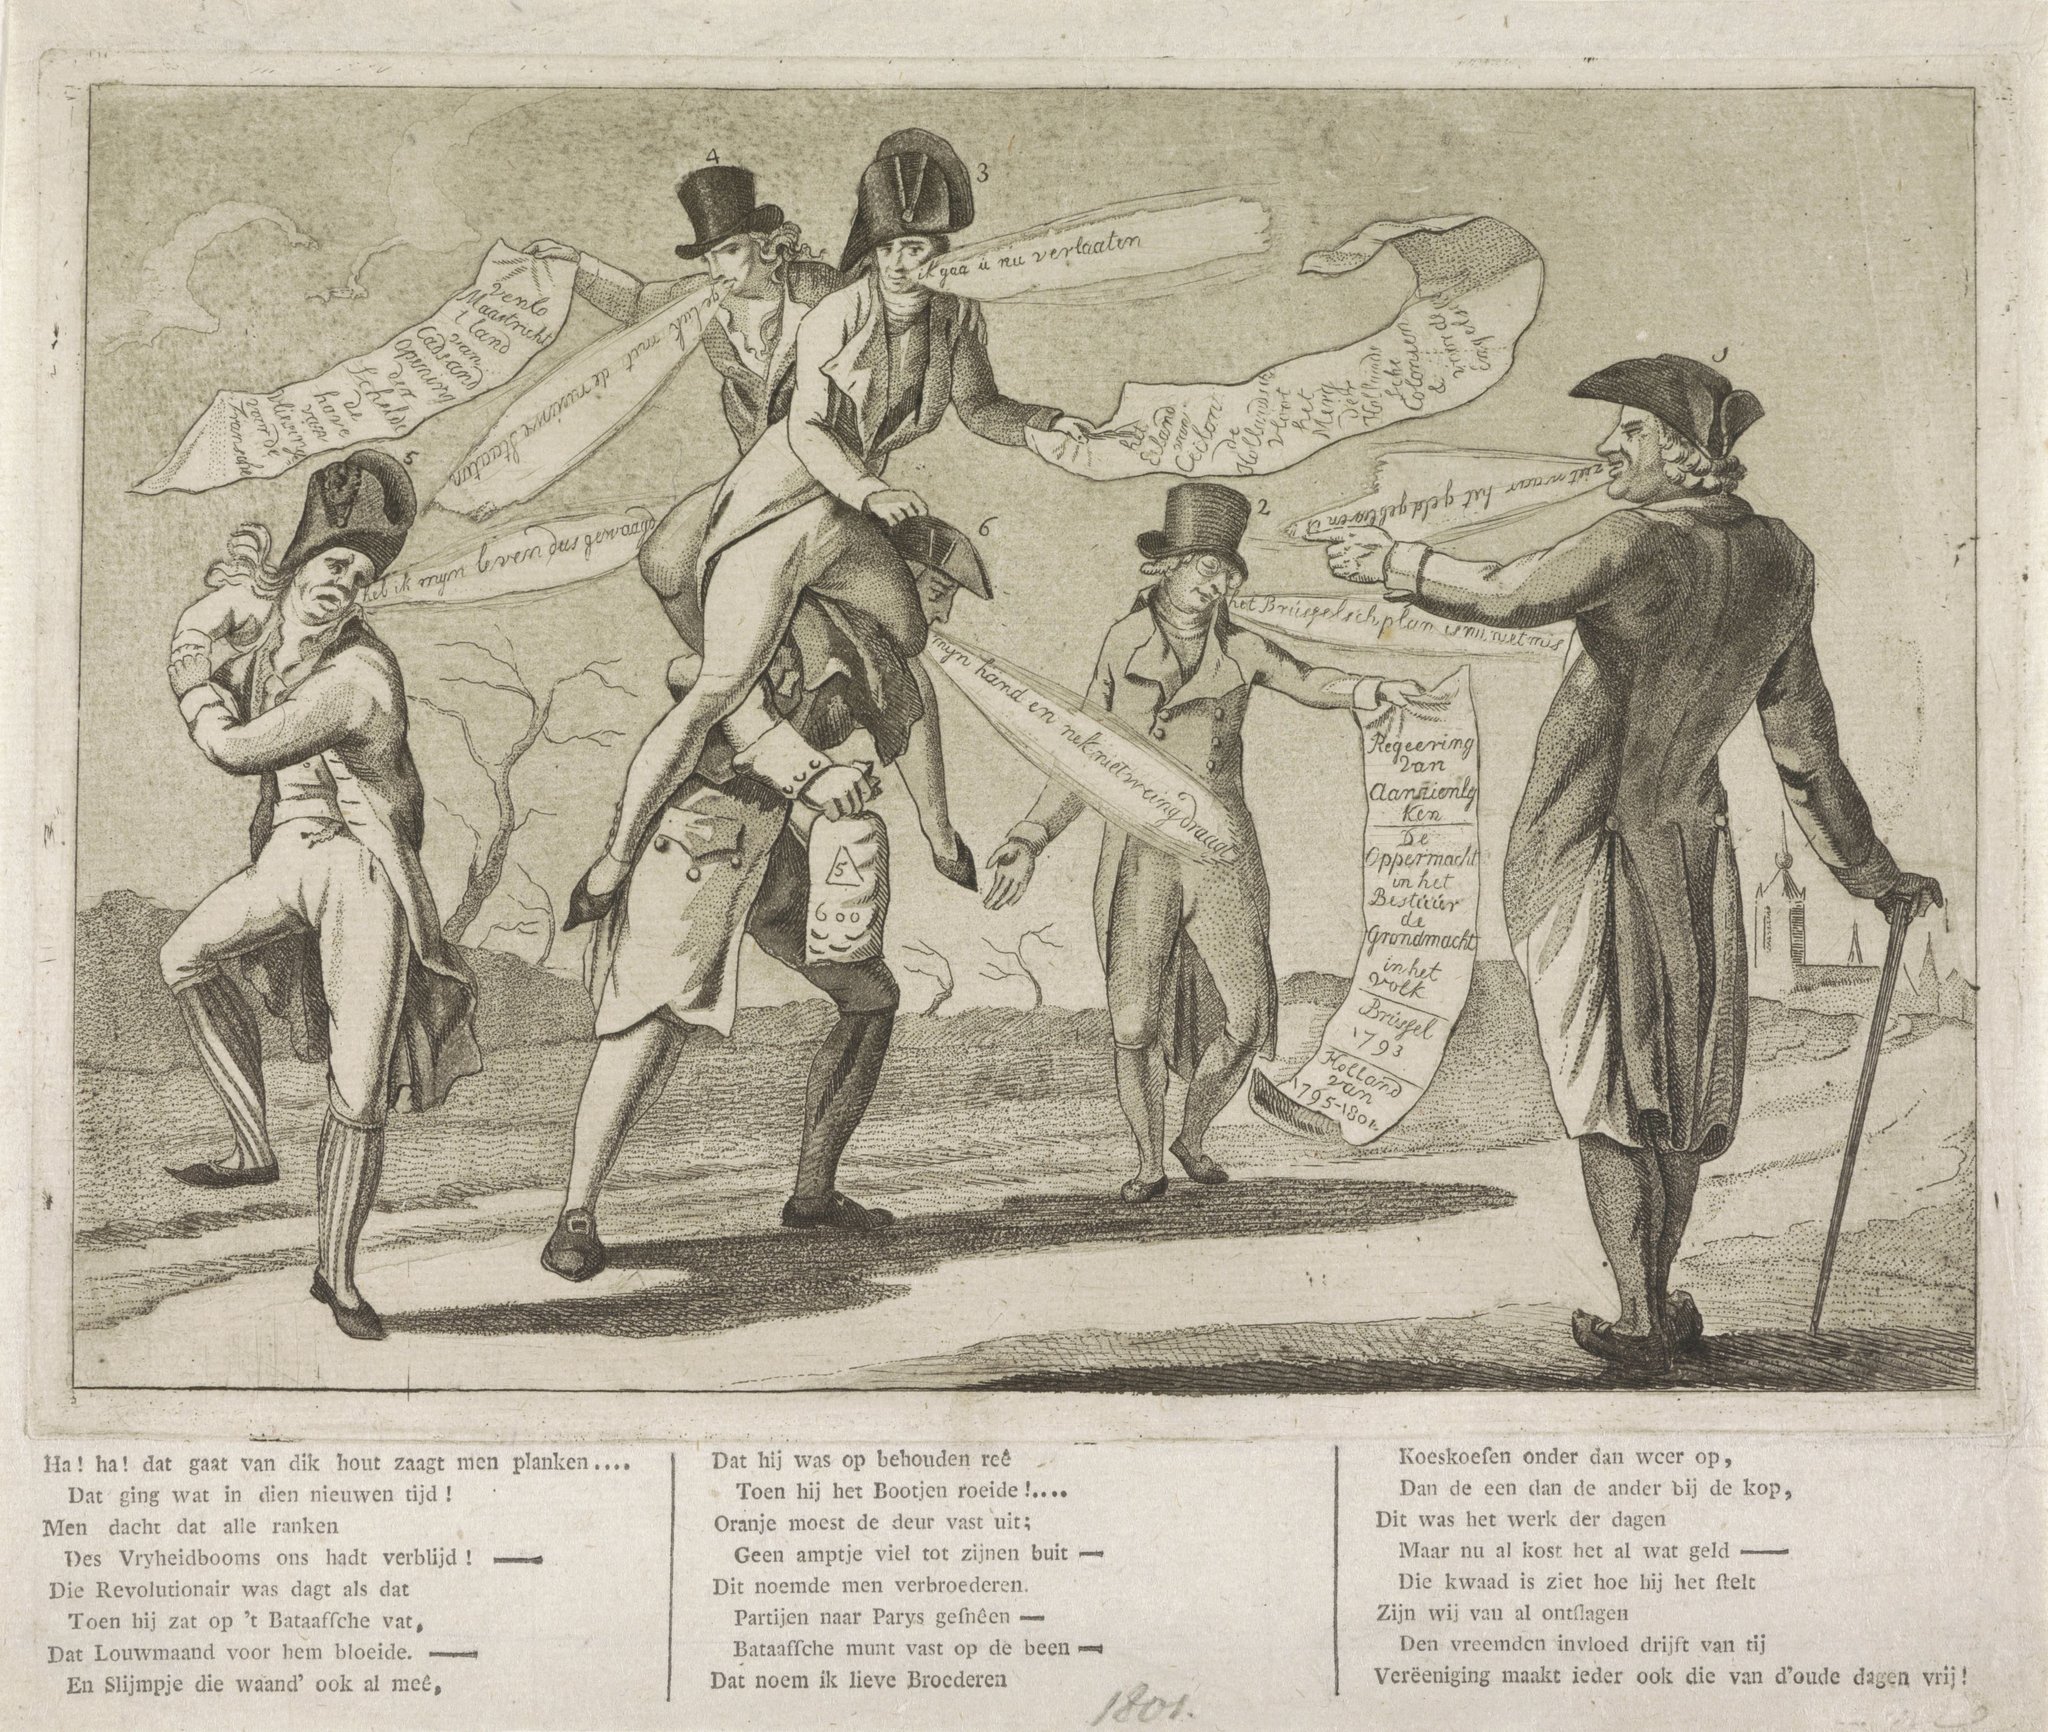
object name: print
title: Spotprent op de vrede van Lunéville, 1801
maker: Anonymous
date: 1801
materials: paper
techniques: aquatint, etching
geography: netherlands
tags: carrying something on the head or on the shoulders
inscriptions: collector's mark: Lugt 2228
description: Spotprent op de vrede van Lunéville gesloten op 9 februari 1801 tussen Frankrijk en Duitsland, en de daarbij door de Bataafse Republiek geleden verliezen. Een Nederlander ziet toe hoe een andere Nederlander op zijn schouders een Fransman en een Brit draagt. Beiden dragen papieren met de namen van de verloren steden en gebieden, waaronder Ceylon, Venlo, Maastricht en Cadzand. Ook met twee andere figuren. Op het blad onder de plaat een vers in drie kolommen.